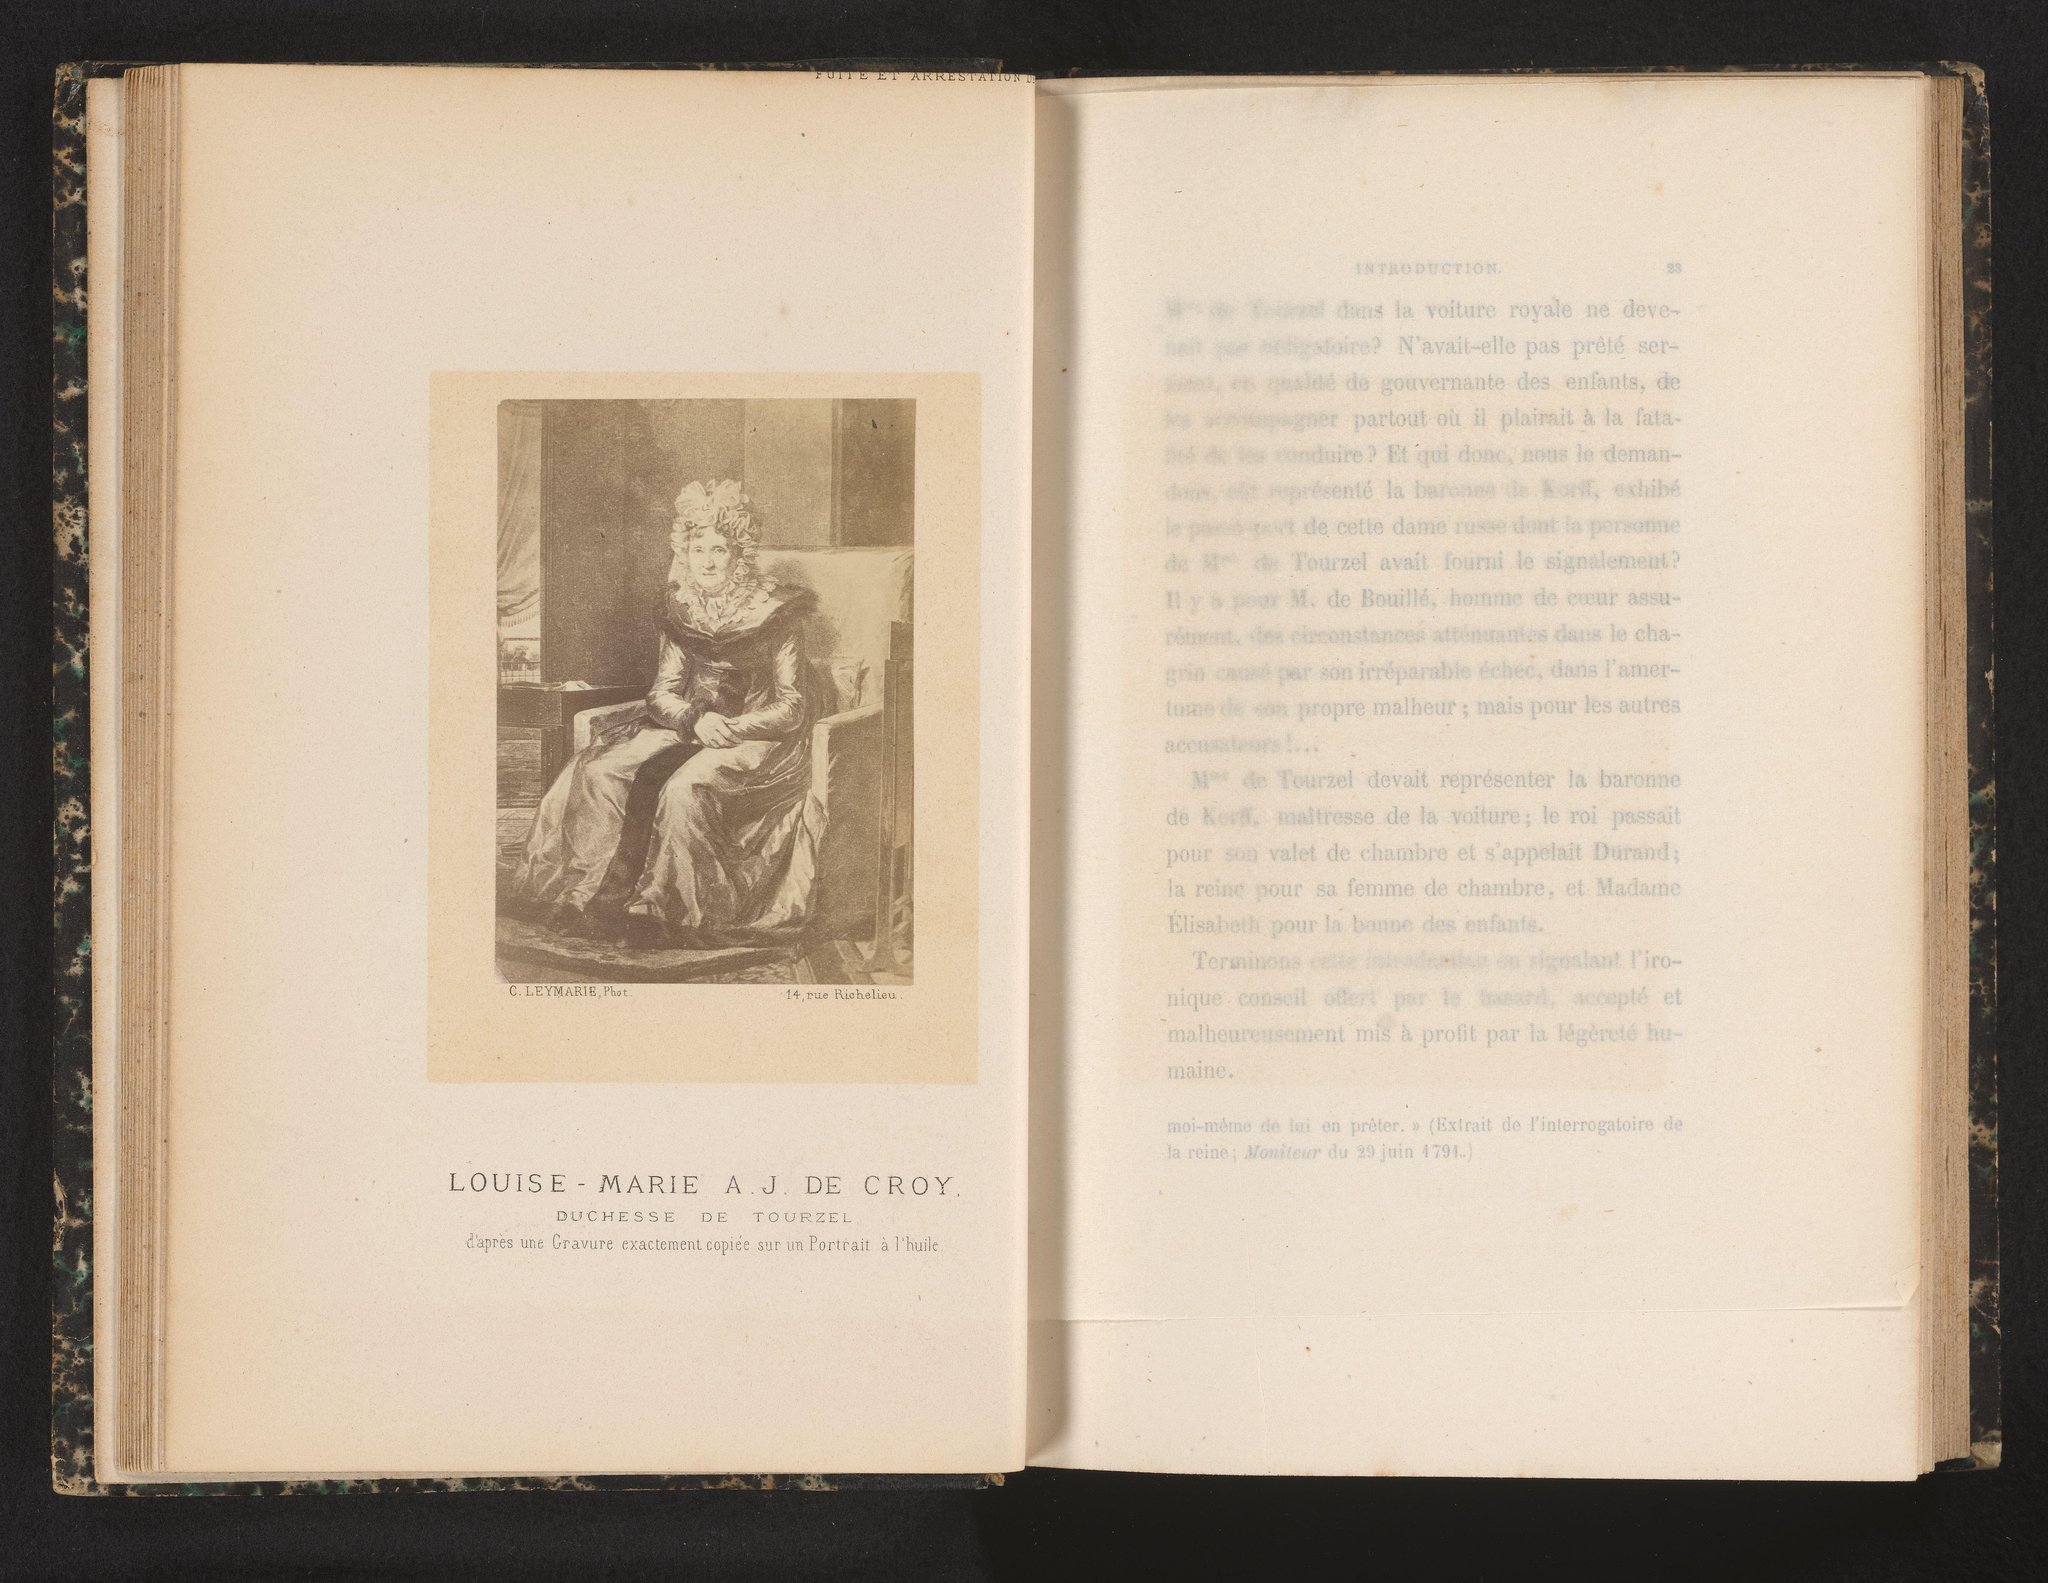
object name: reproduction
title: Louise Marie A.J. de Croy. Duchesse de Tourzel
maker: charles leymarie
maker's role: fotograaf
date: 1856-1866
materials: paper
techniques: albumen print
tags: historical persons - bb - woman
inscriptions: address: ‘14, rue Richelieu’, inscription: ‘d'après une Gravure exactement copiée sur un Portrait à l'huile’